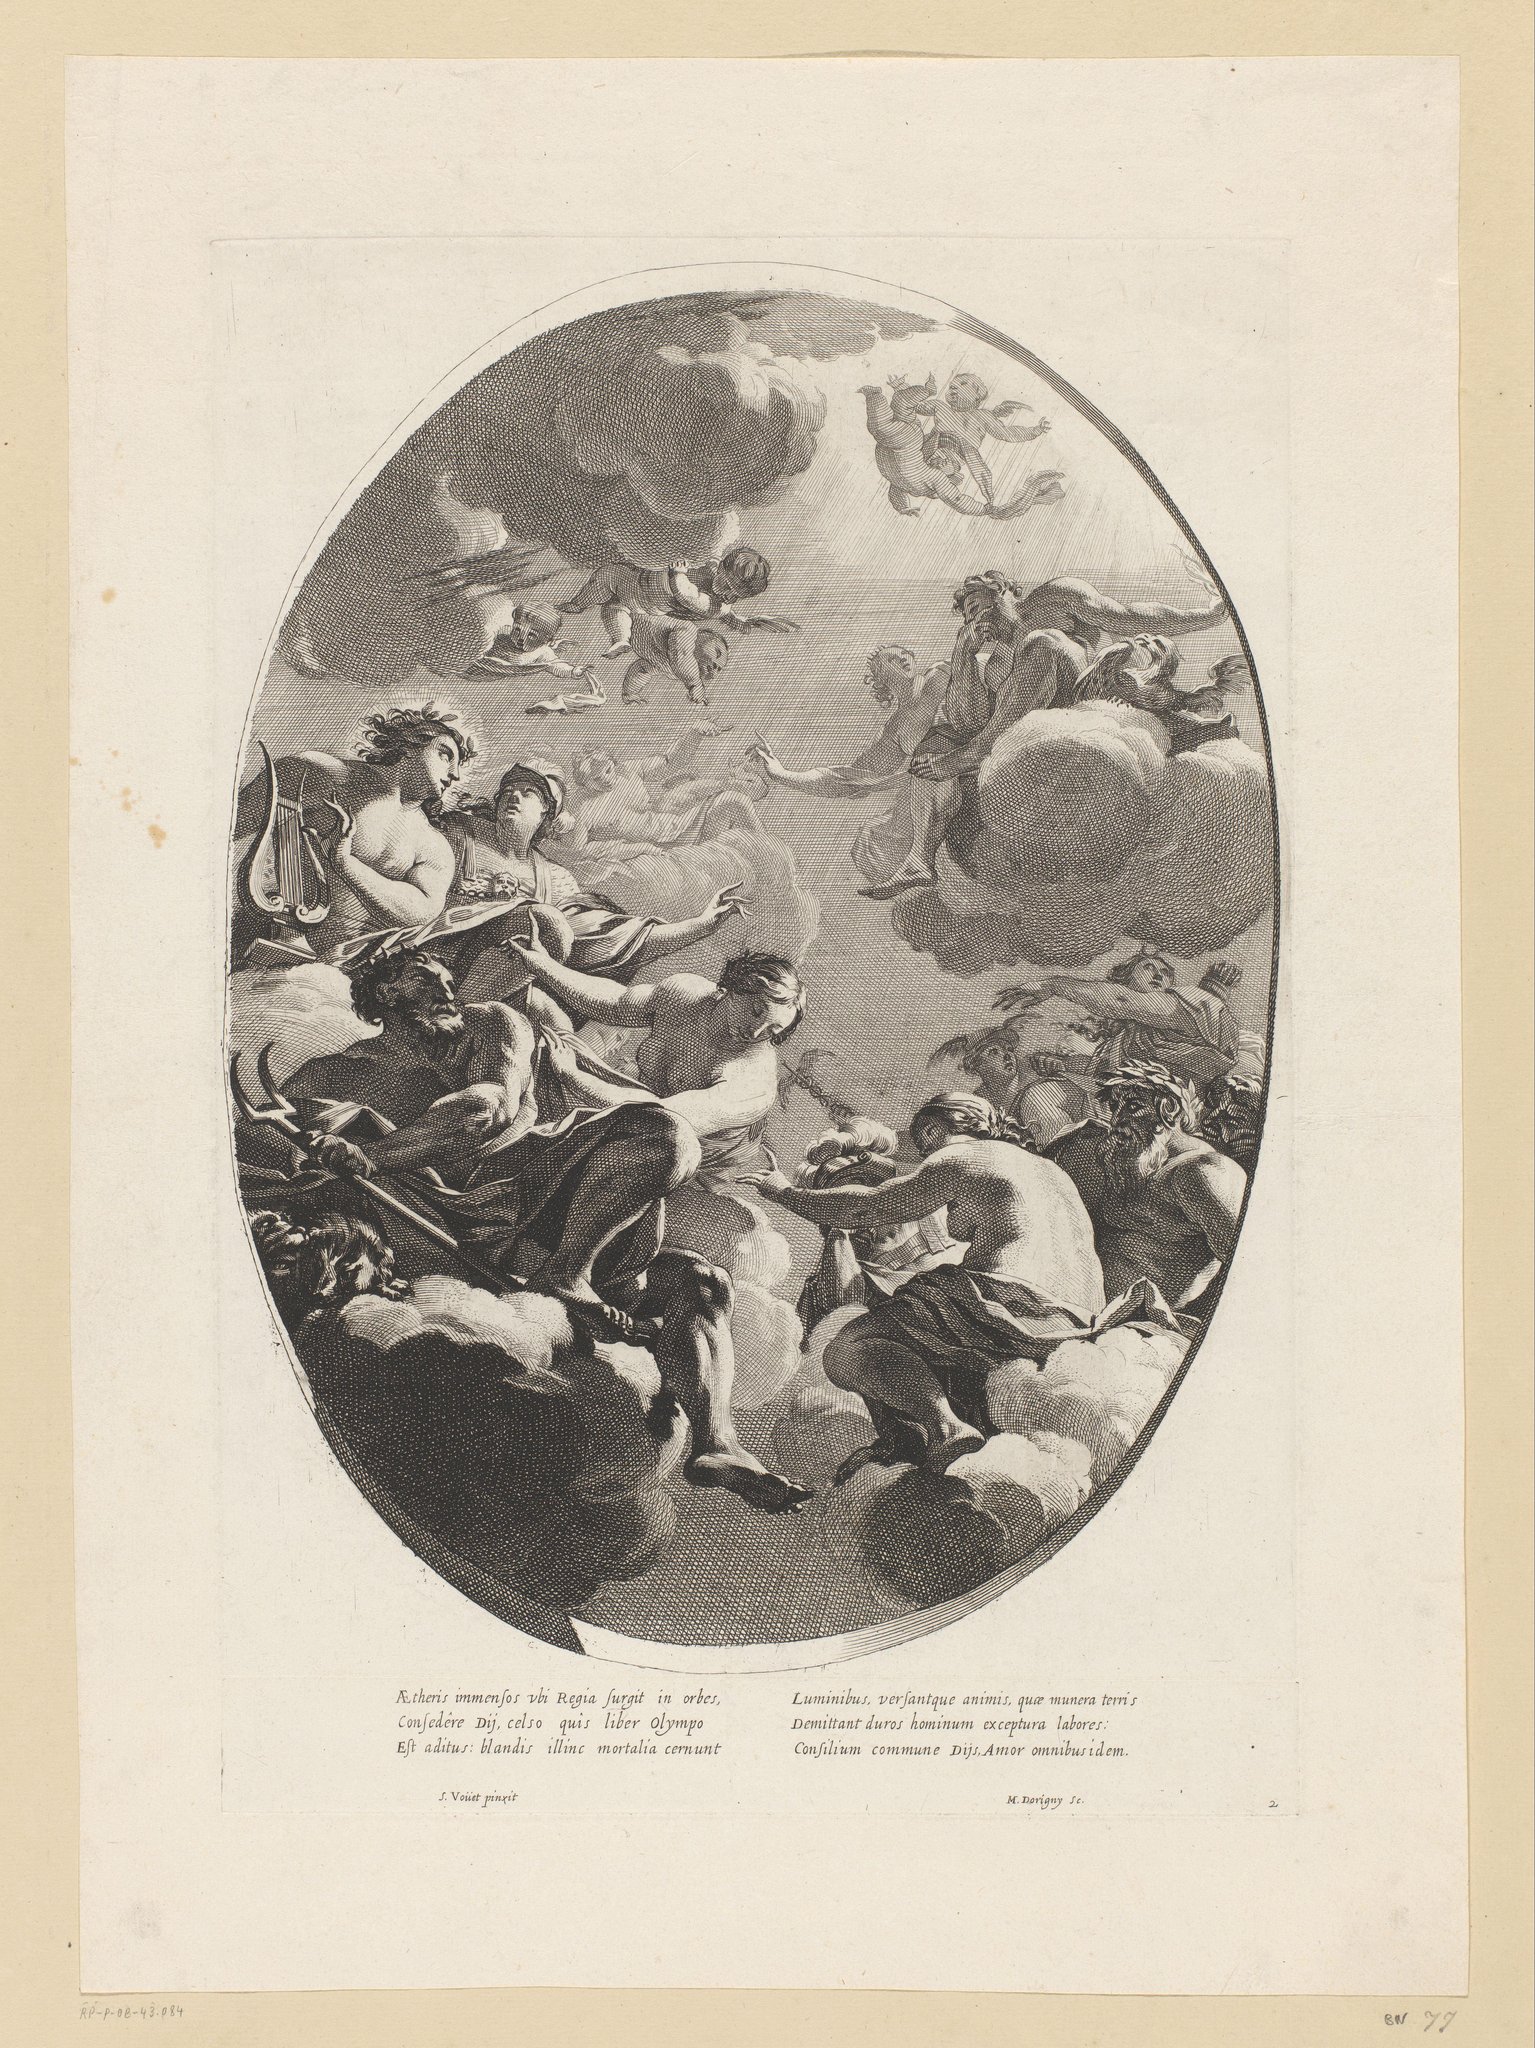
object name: print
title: Serie naar schilderijen door Vouet voor de bibliotheek van het Hôtel Séguier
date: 1640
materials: paper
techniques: engraving, etching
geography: france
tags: the olympian gods together: jupiter, juno, neptune, ceres, apollo, diana, mars, venus, mercury, minerva, vulcan, vesta (or bacchus)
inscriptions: watermark, collector's mark: Lugt 240